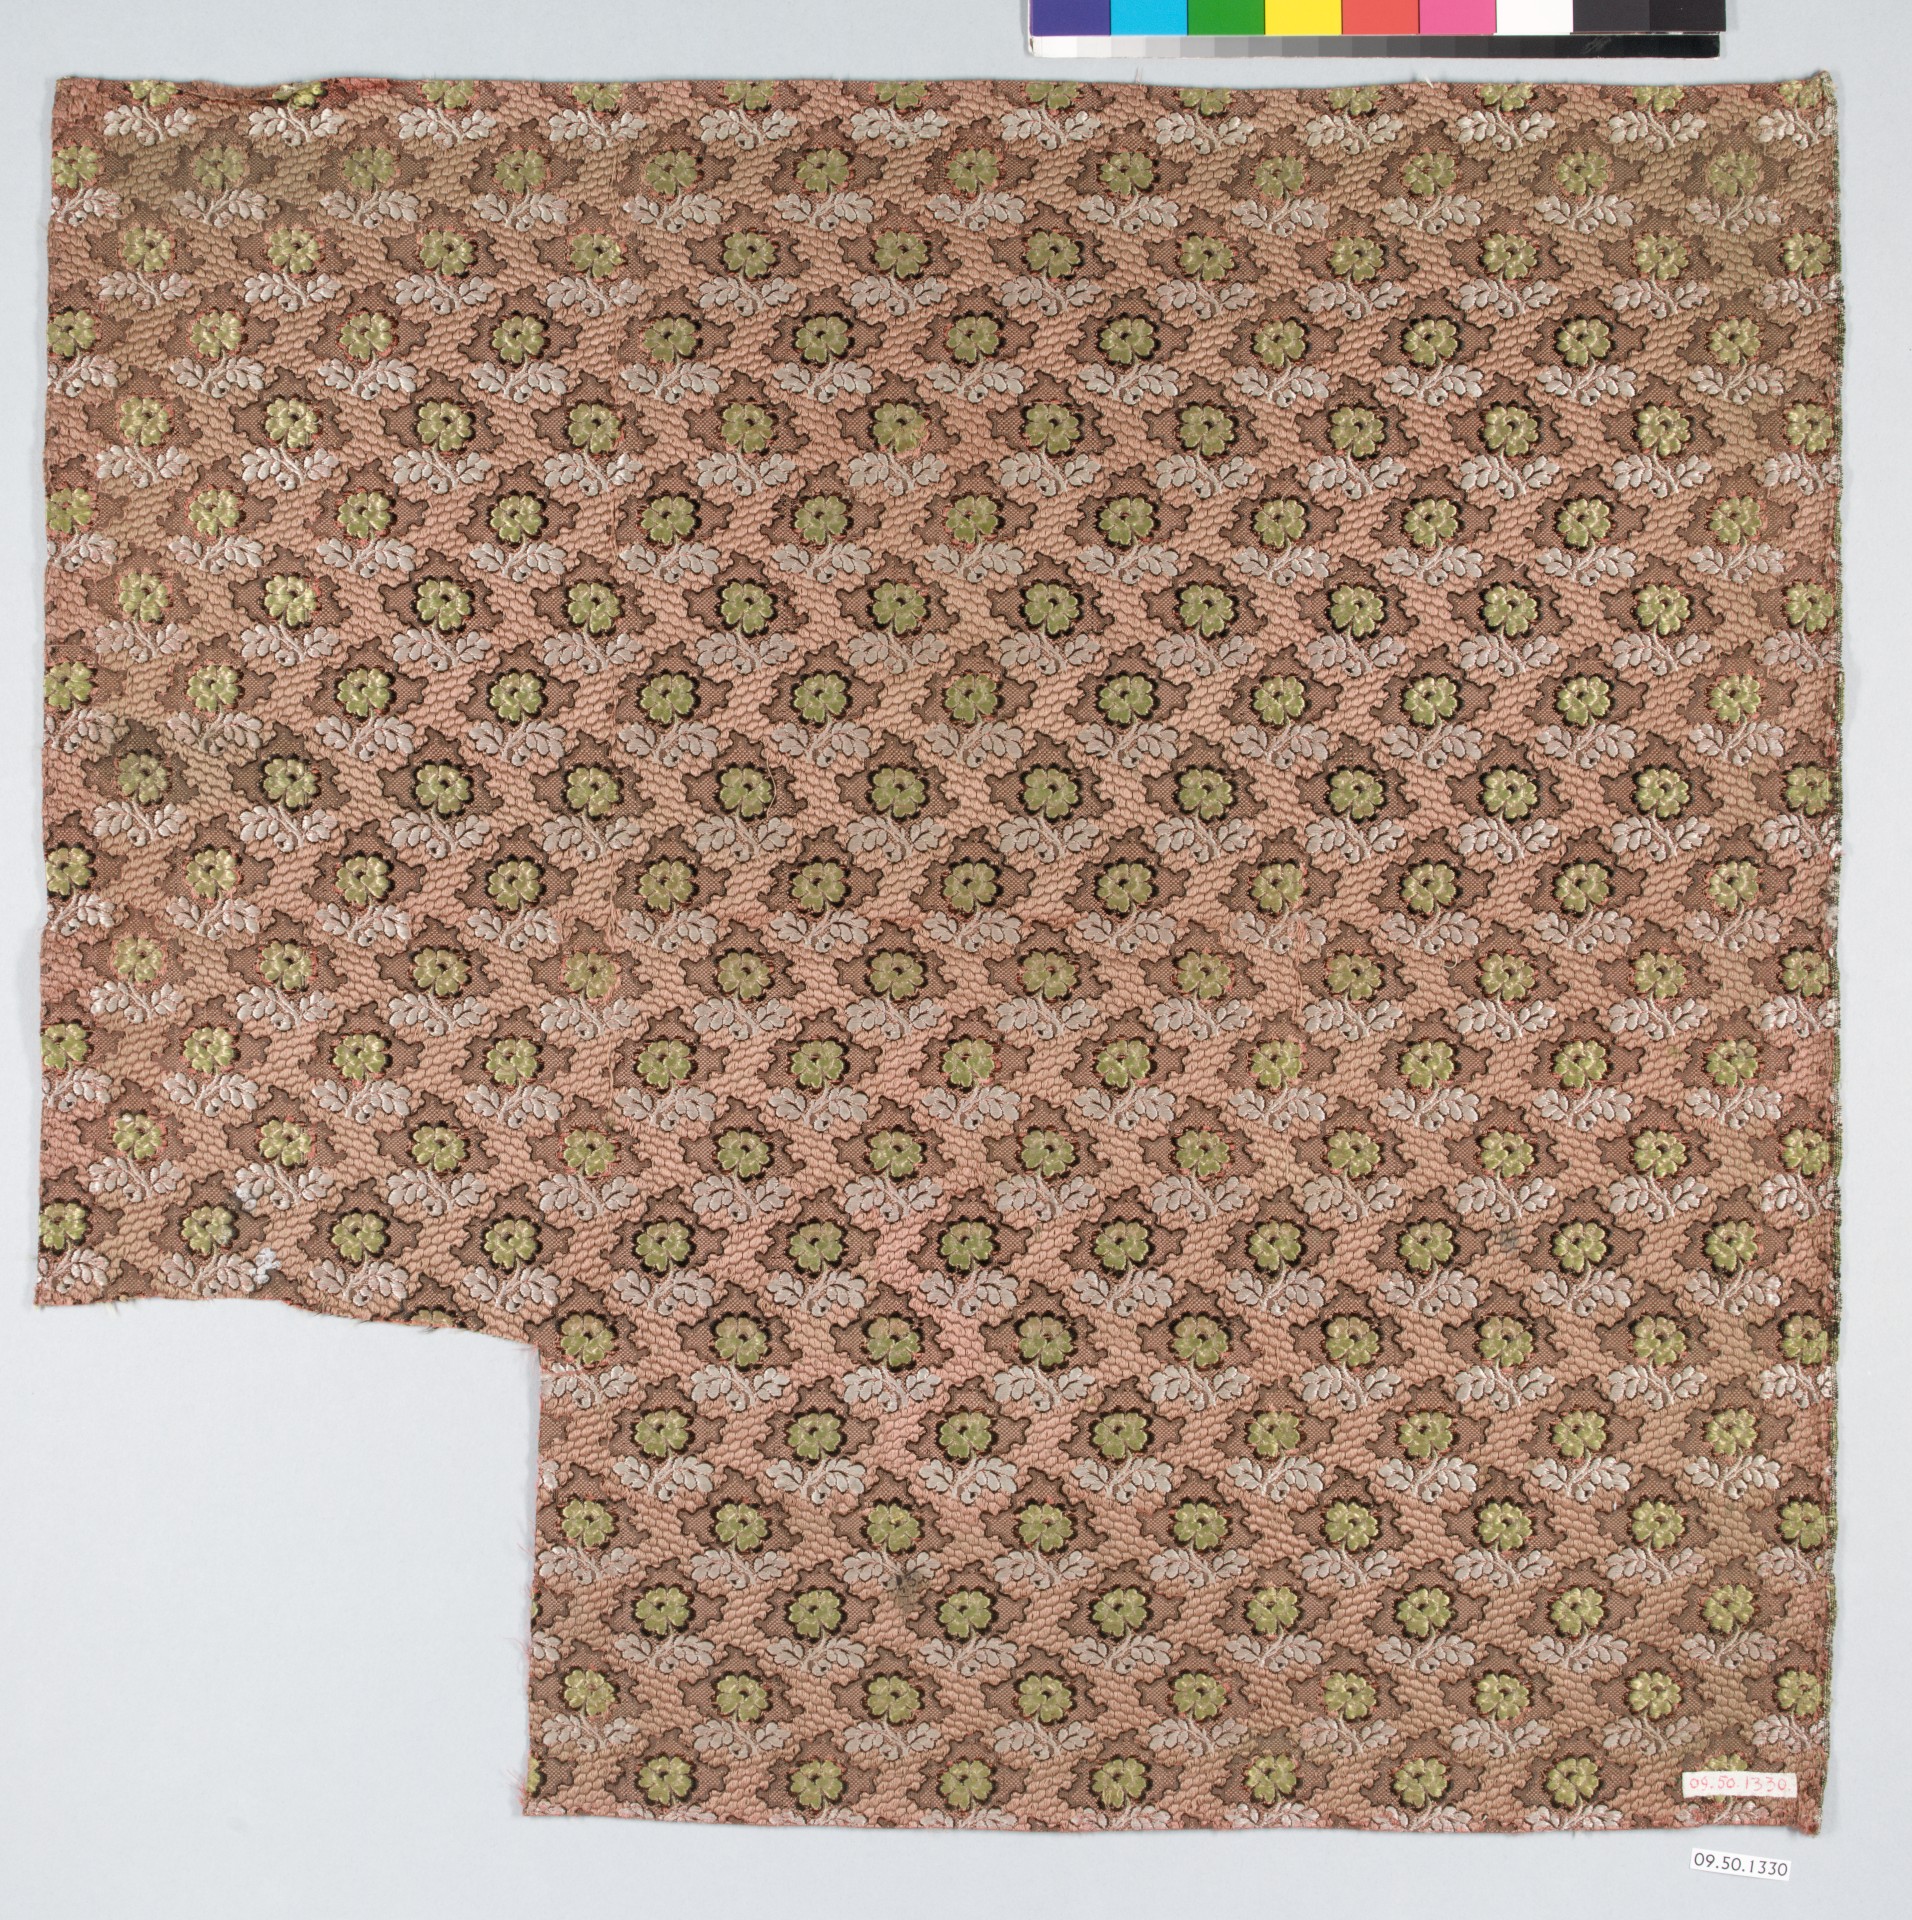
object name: piece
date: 1767-1800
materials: silk